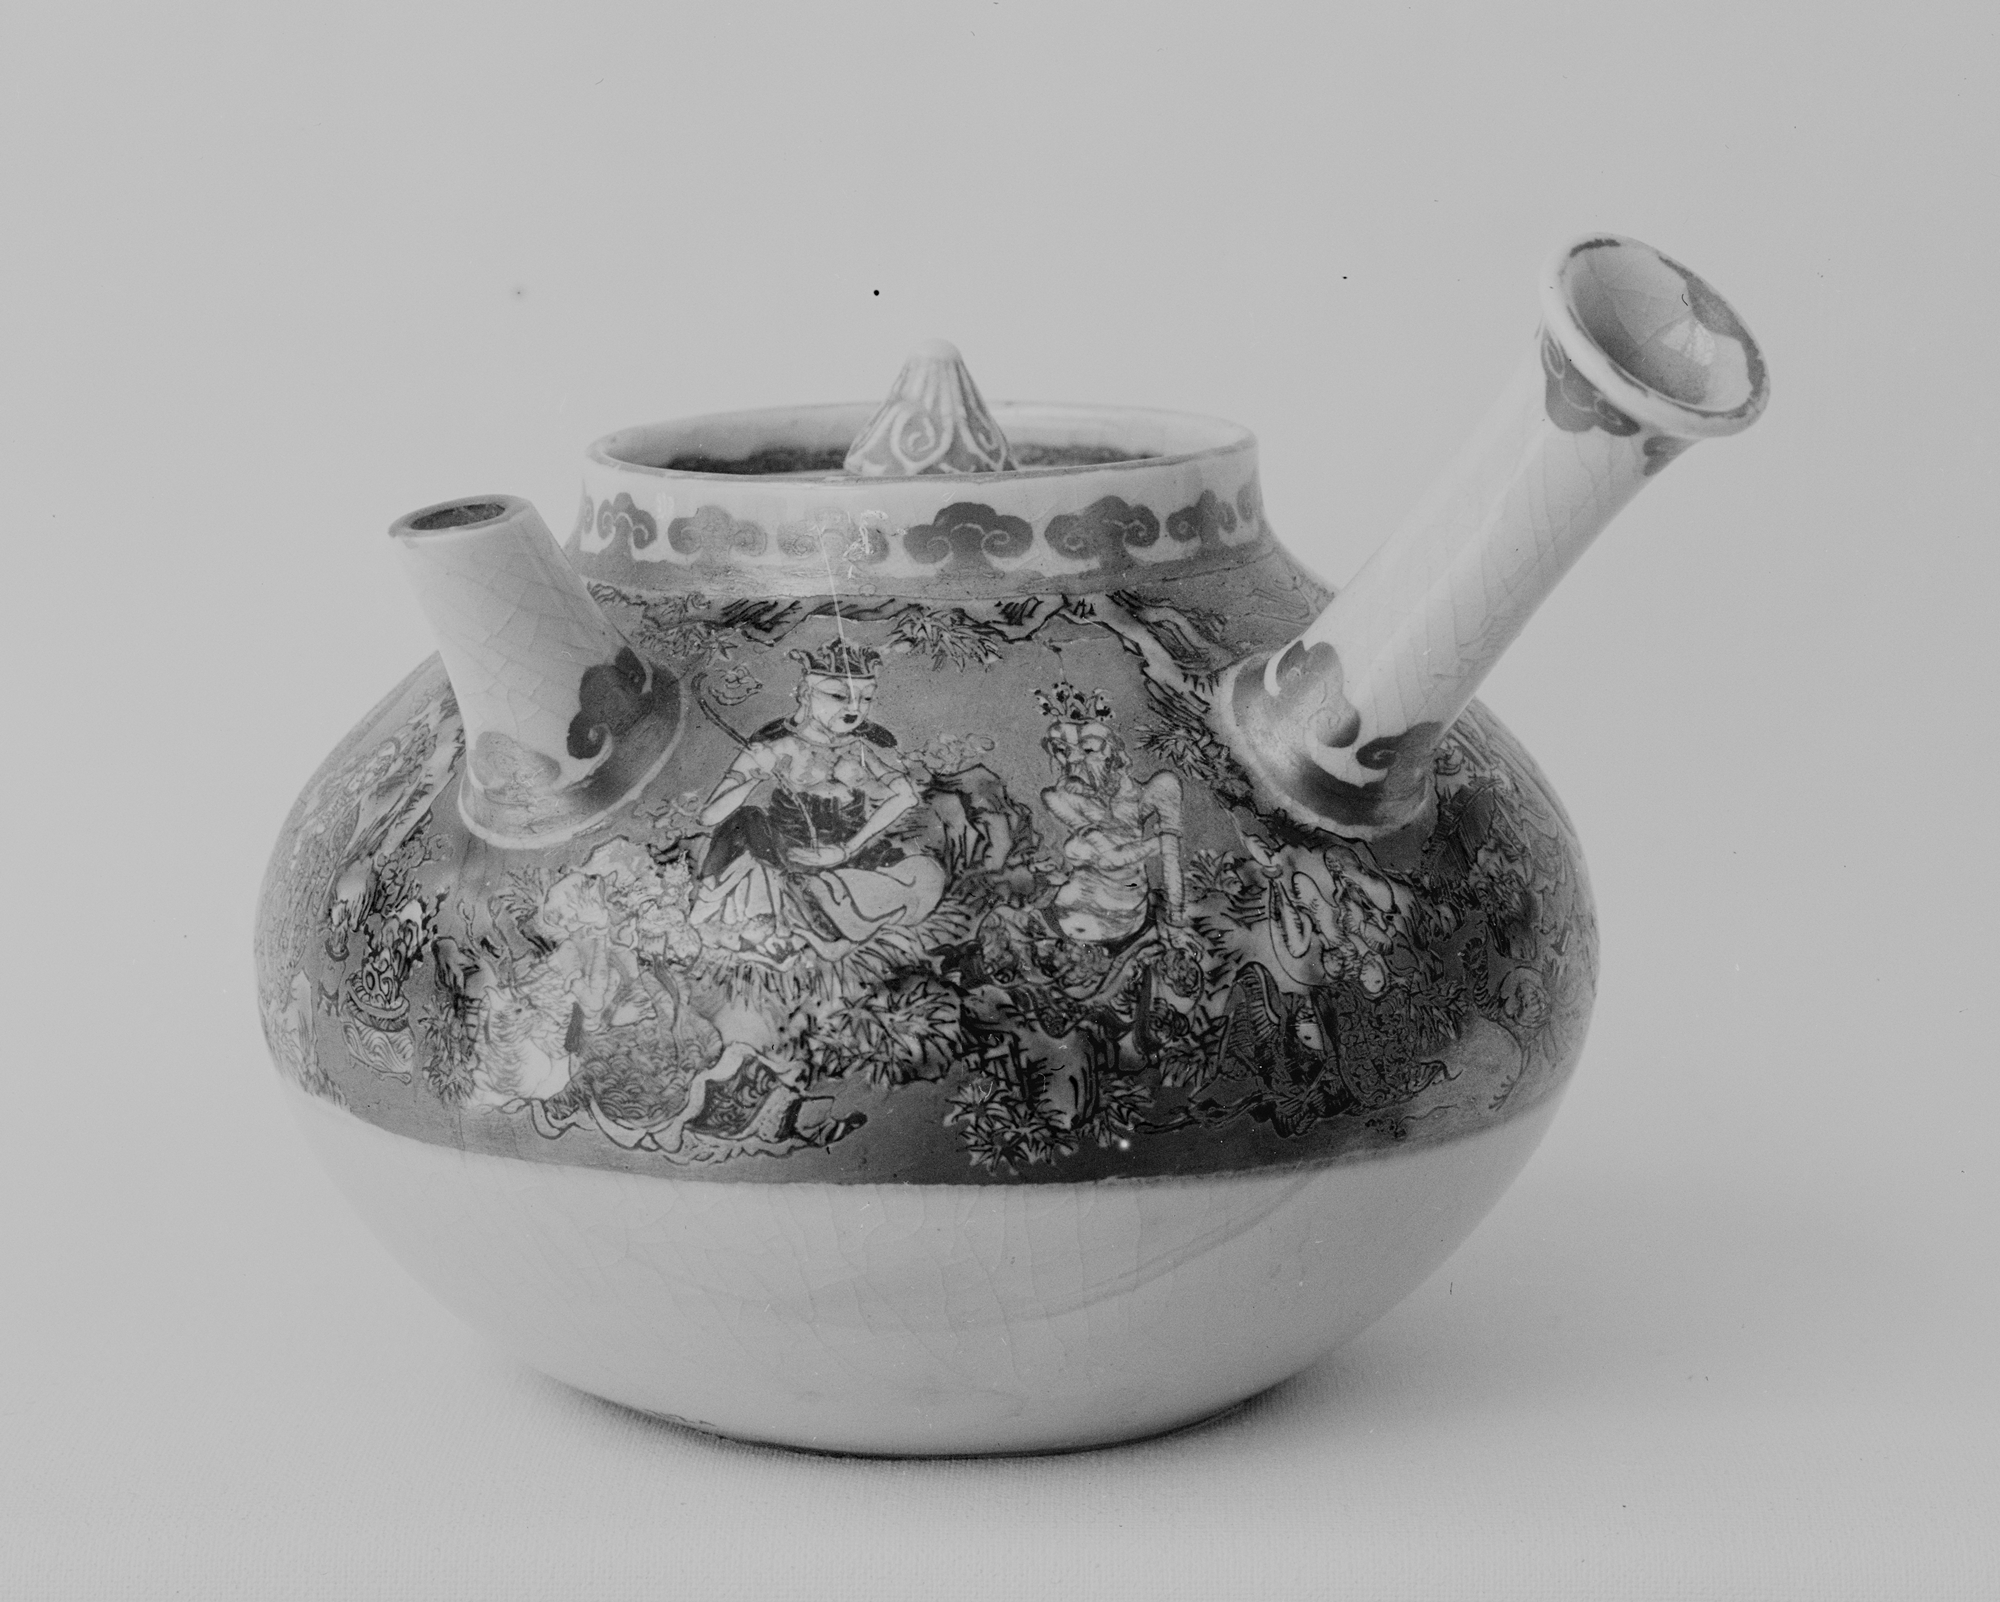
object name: teapot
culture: japanese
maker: shuhei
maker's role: artist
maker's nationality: japanese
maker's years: 1788-1839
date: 1800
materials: clay, enamel, glaze, gold leaf